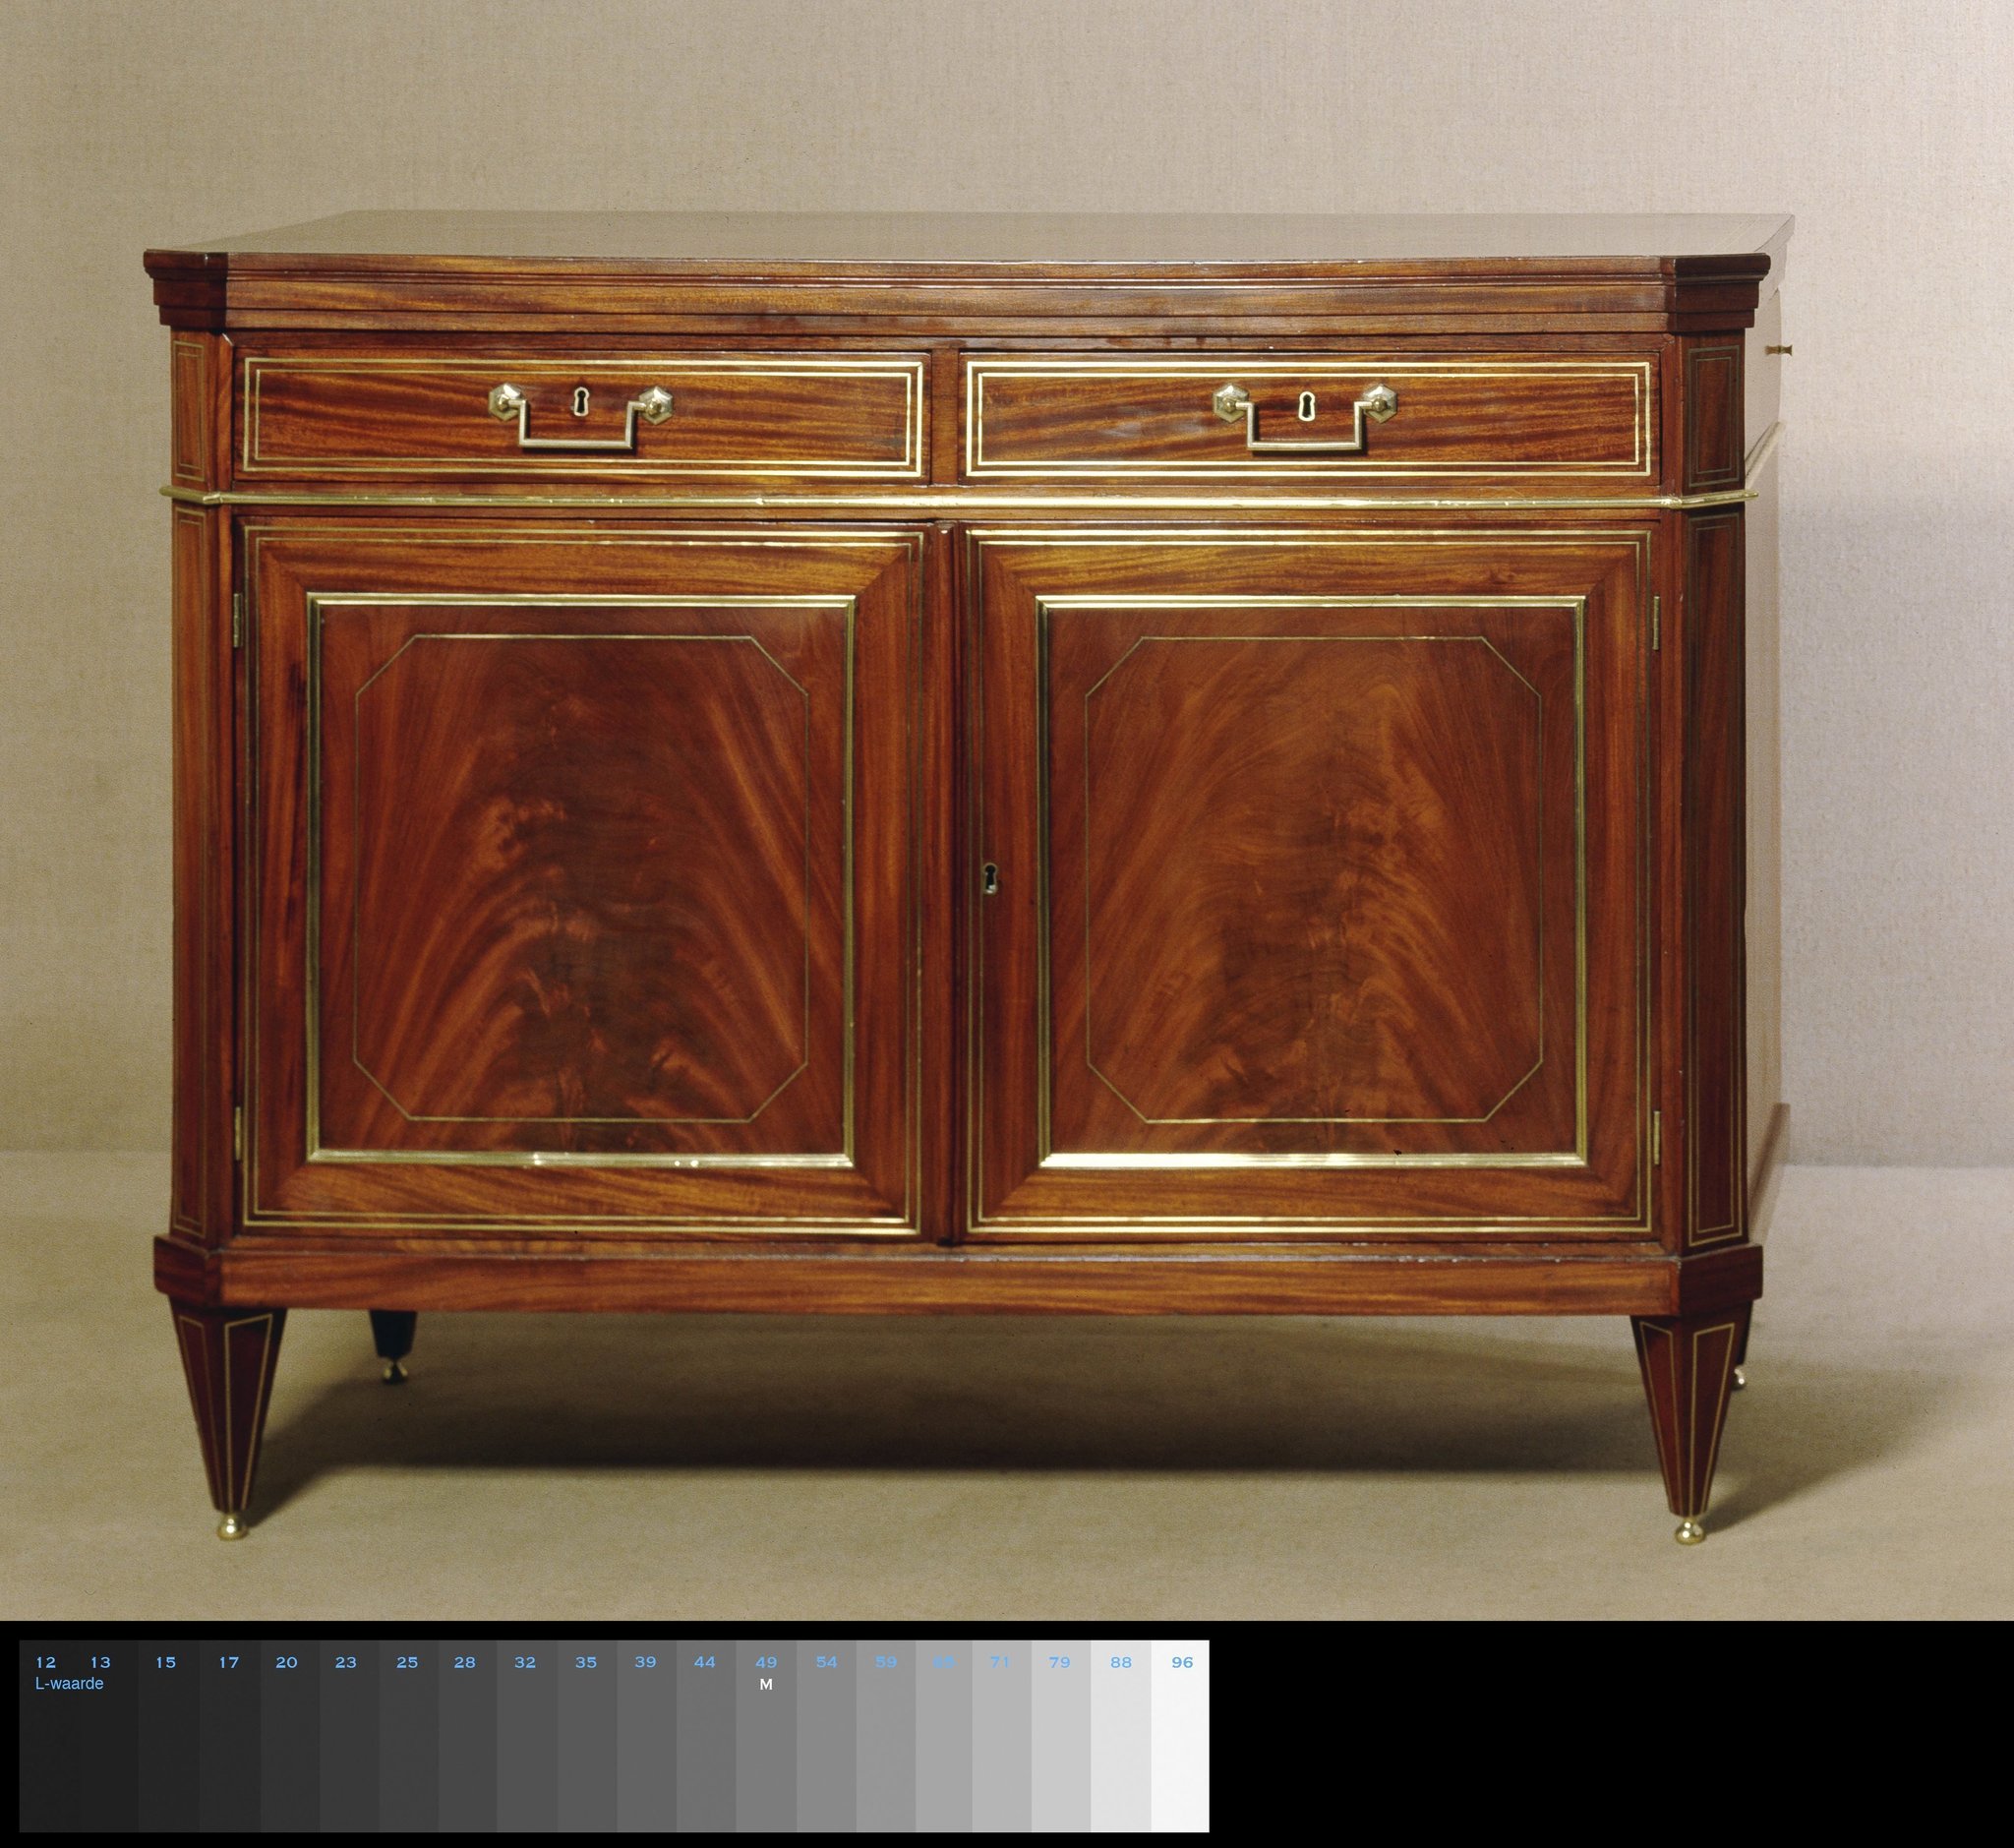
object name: furniture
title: Buffet van eikenhout, gefineerd met mahoniehout en ingelegd met koperen biezen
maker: carel breytspraak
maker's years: 1808-1810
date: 1805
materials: brass, wood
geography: amsterdam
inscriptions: signature and date: ‘C. Breijtspraak // Inde // vijselstraat // te // Amsterdam // 1805’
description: Buffet. Eikenhout, gefineerd met mahoniehout, ingelegd met koper. Amsterdam, 1805, door Carel Breytspraak.